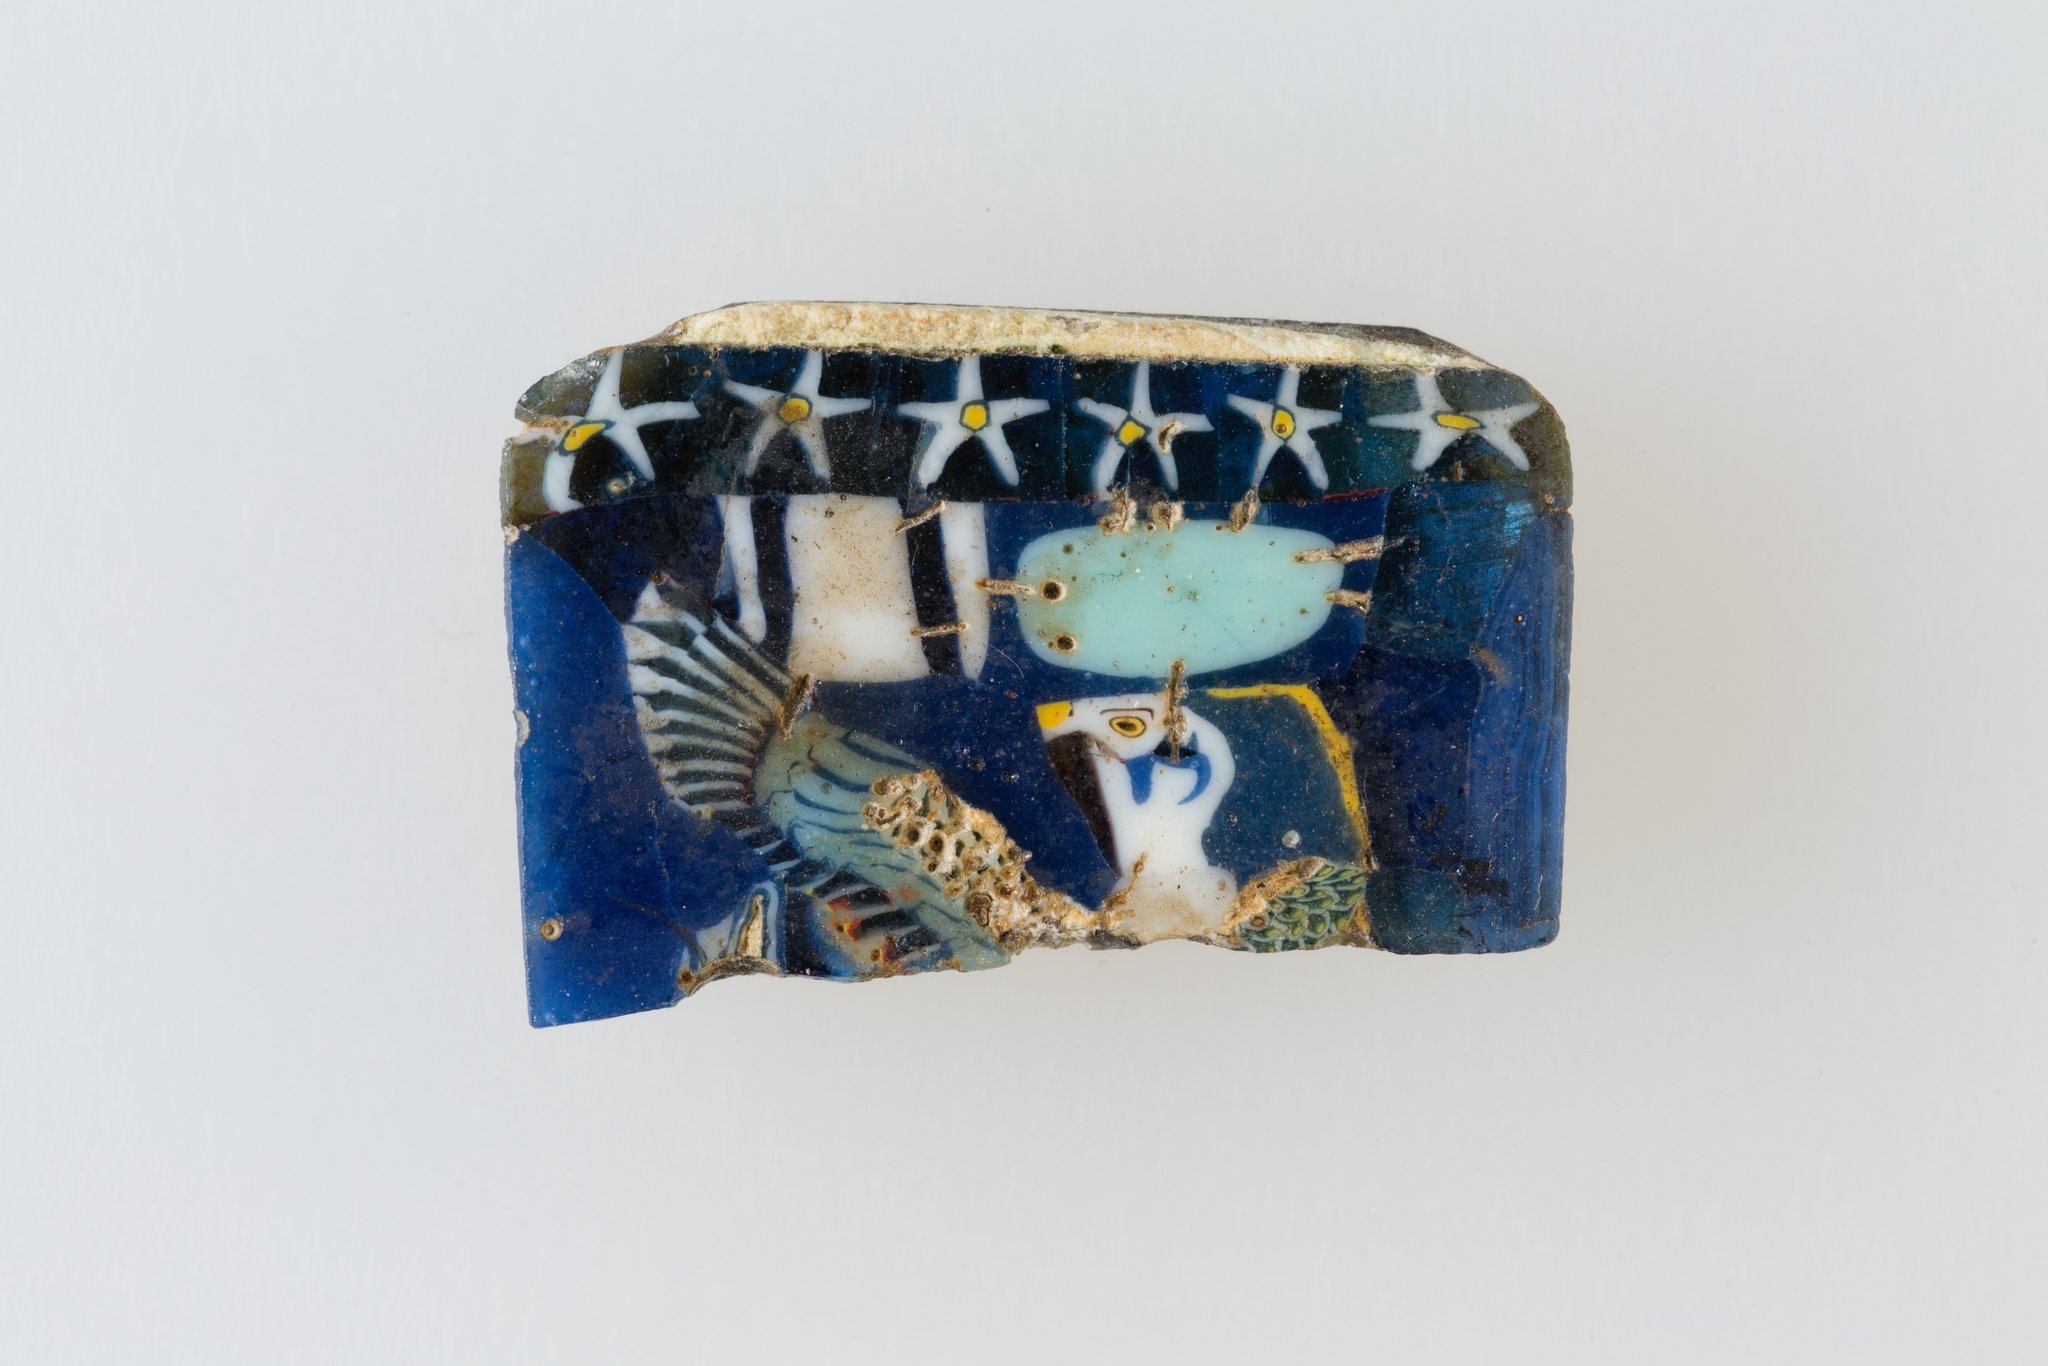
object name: plaque, falcon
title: Inlay, falcon with spread wings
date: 100 BCE-100 CE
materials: glass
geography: egypt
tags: falcons